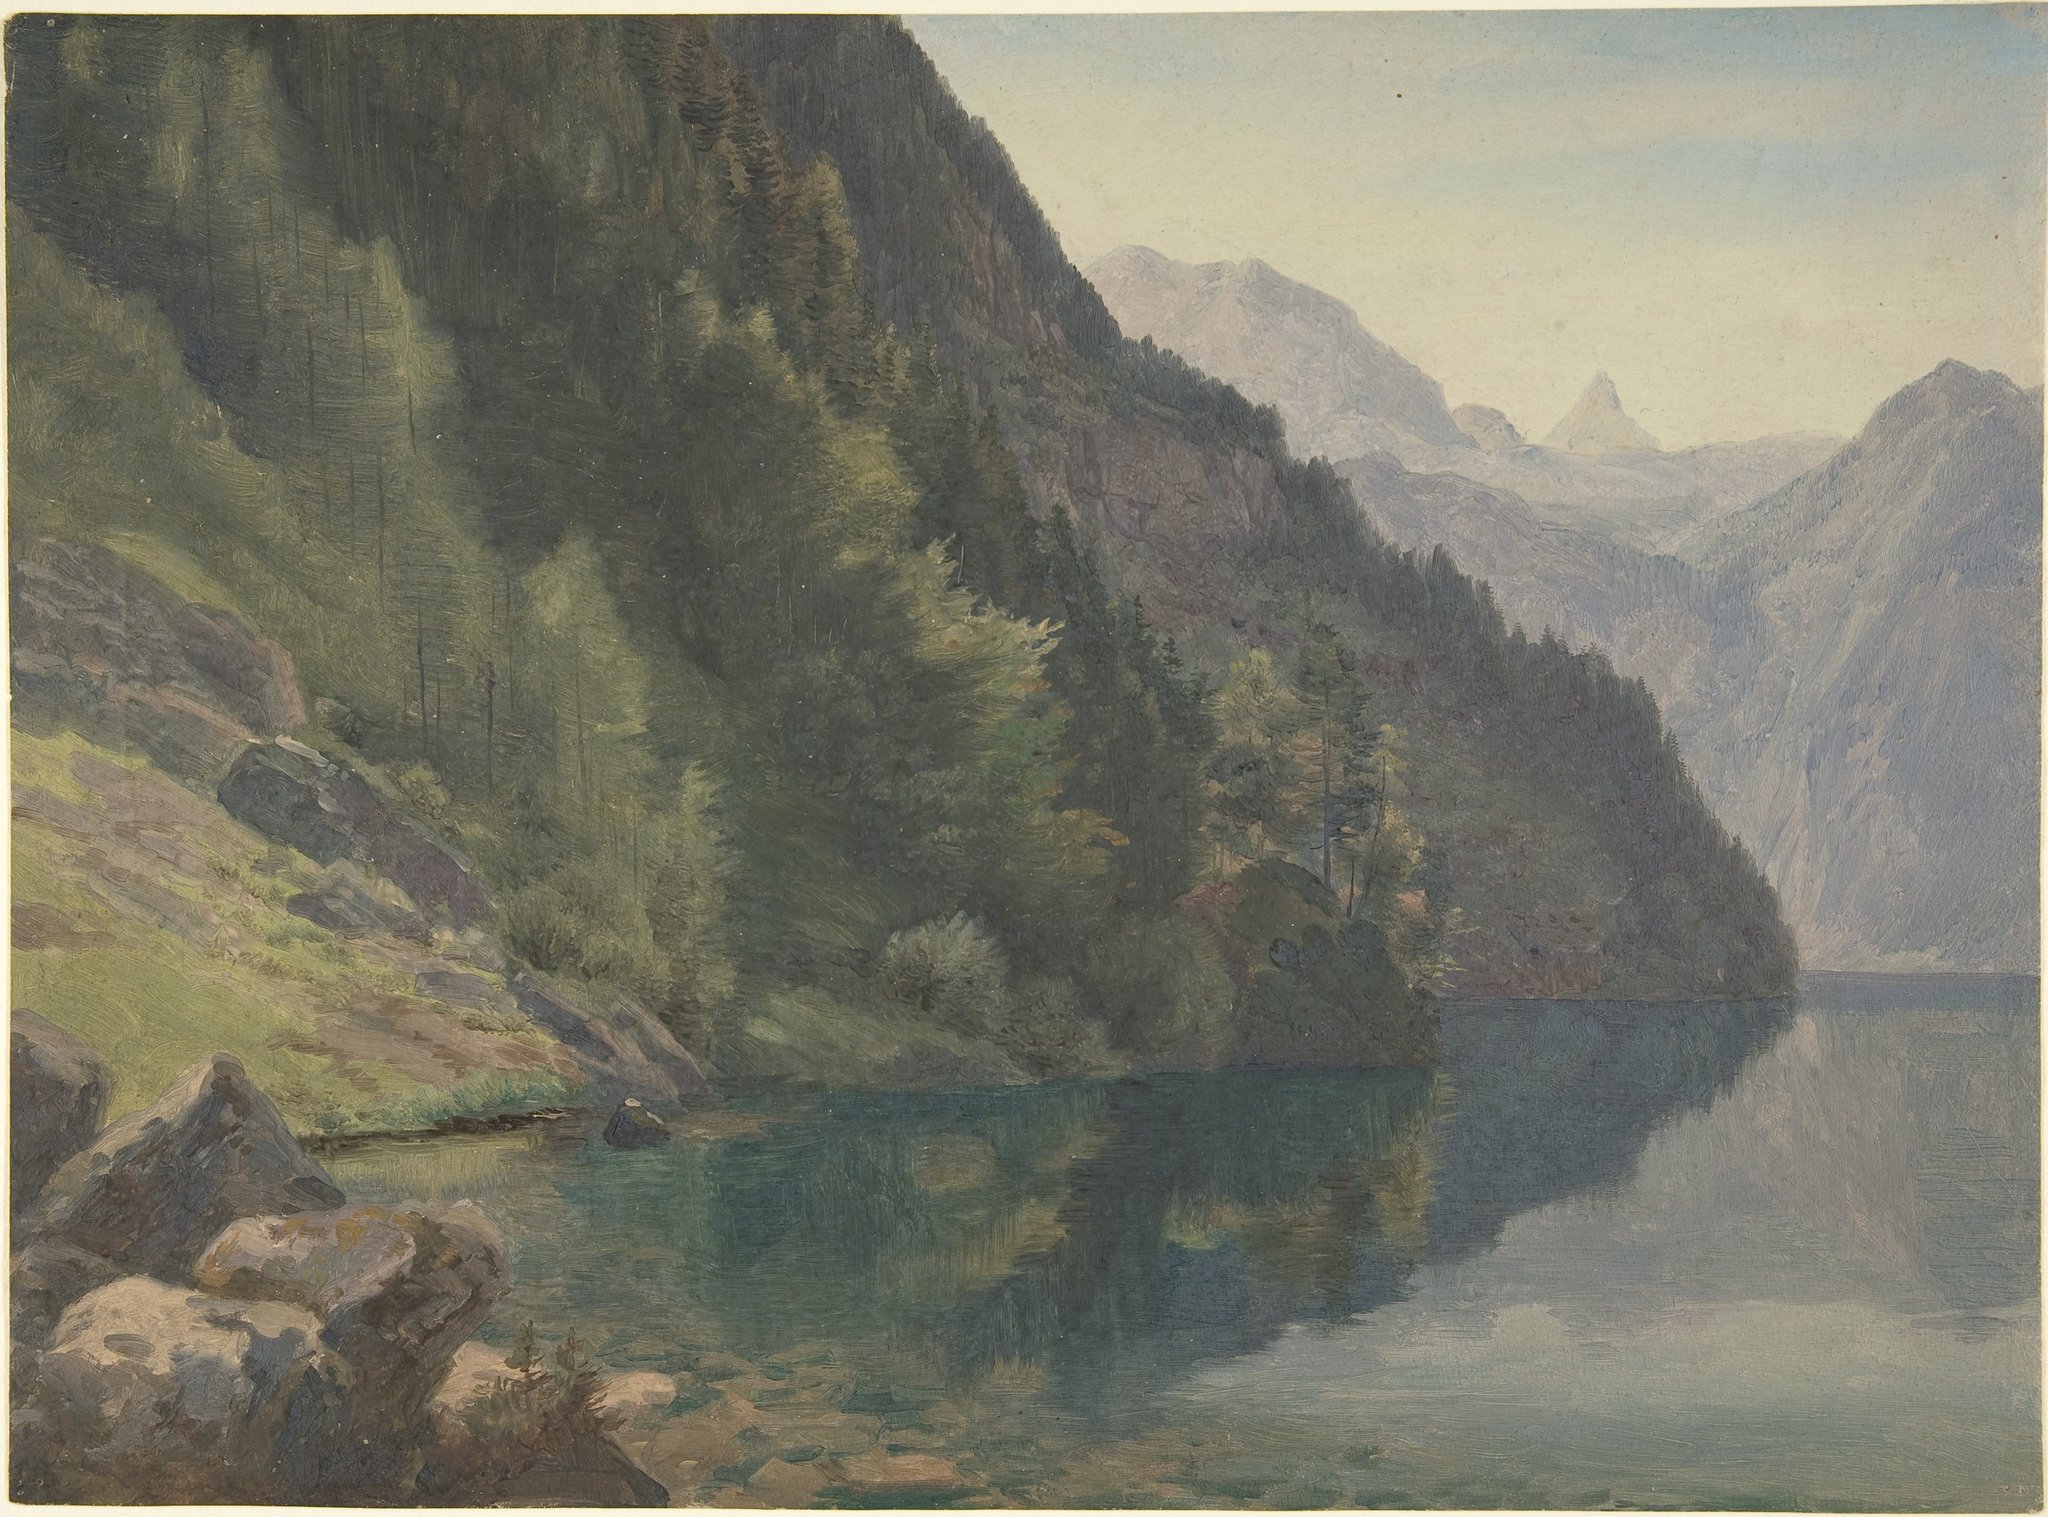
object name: drawing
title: Wooded Shore at the King's Lake (Königssee)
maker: johann heinrich schilbach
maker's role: artist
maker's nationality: german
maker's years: 1798-1851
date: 1801-1850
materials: paint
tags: lakes,mountains,trees